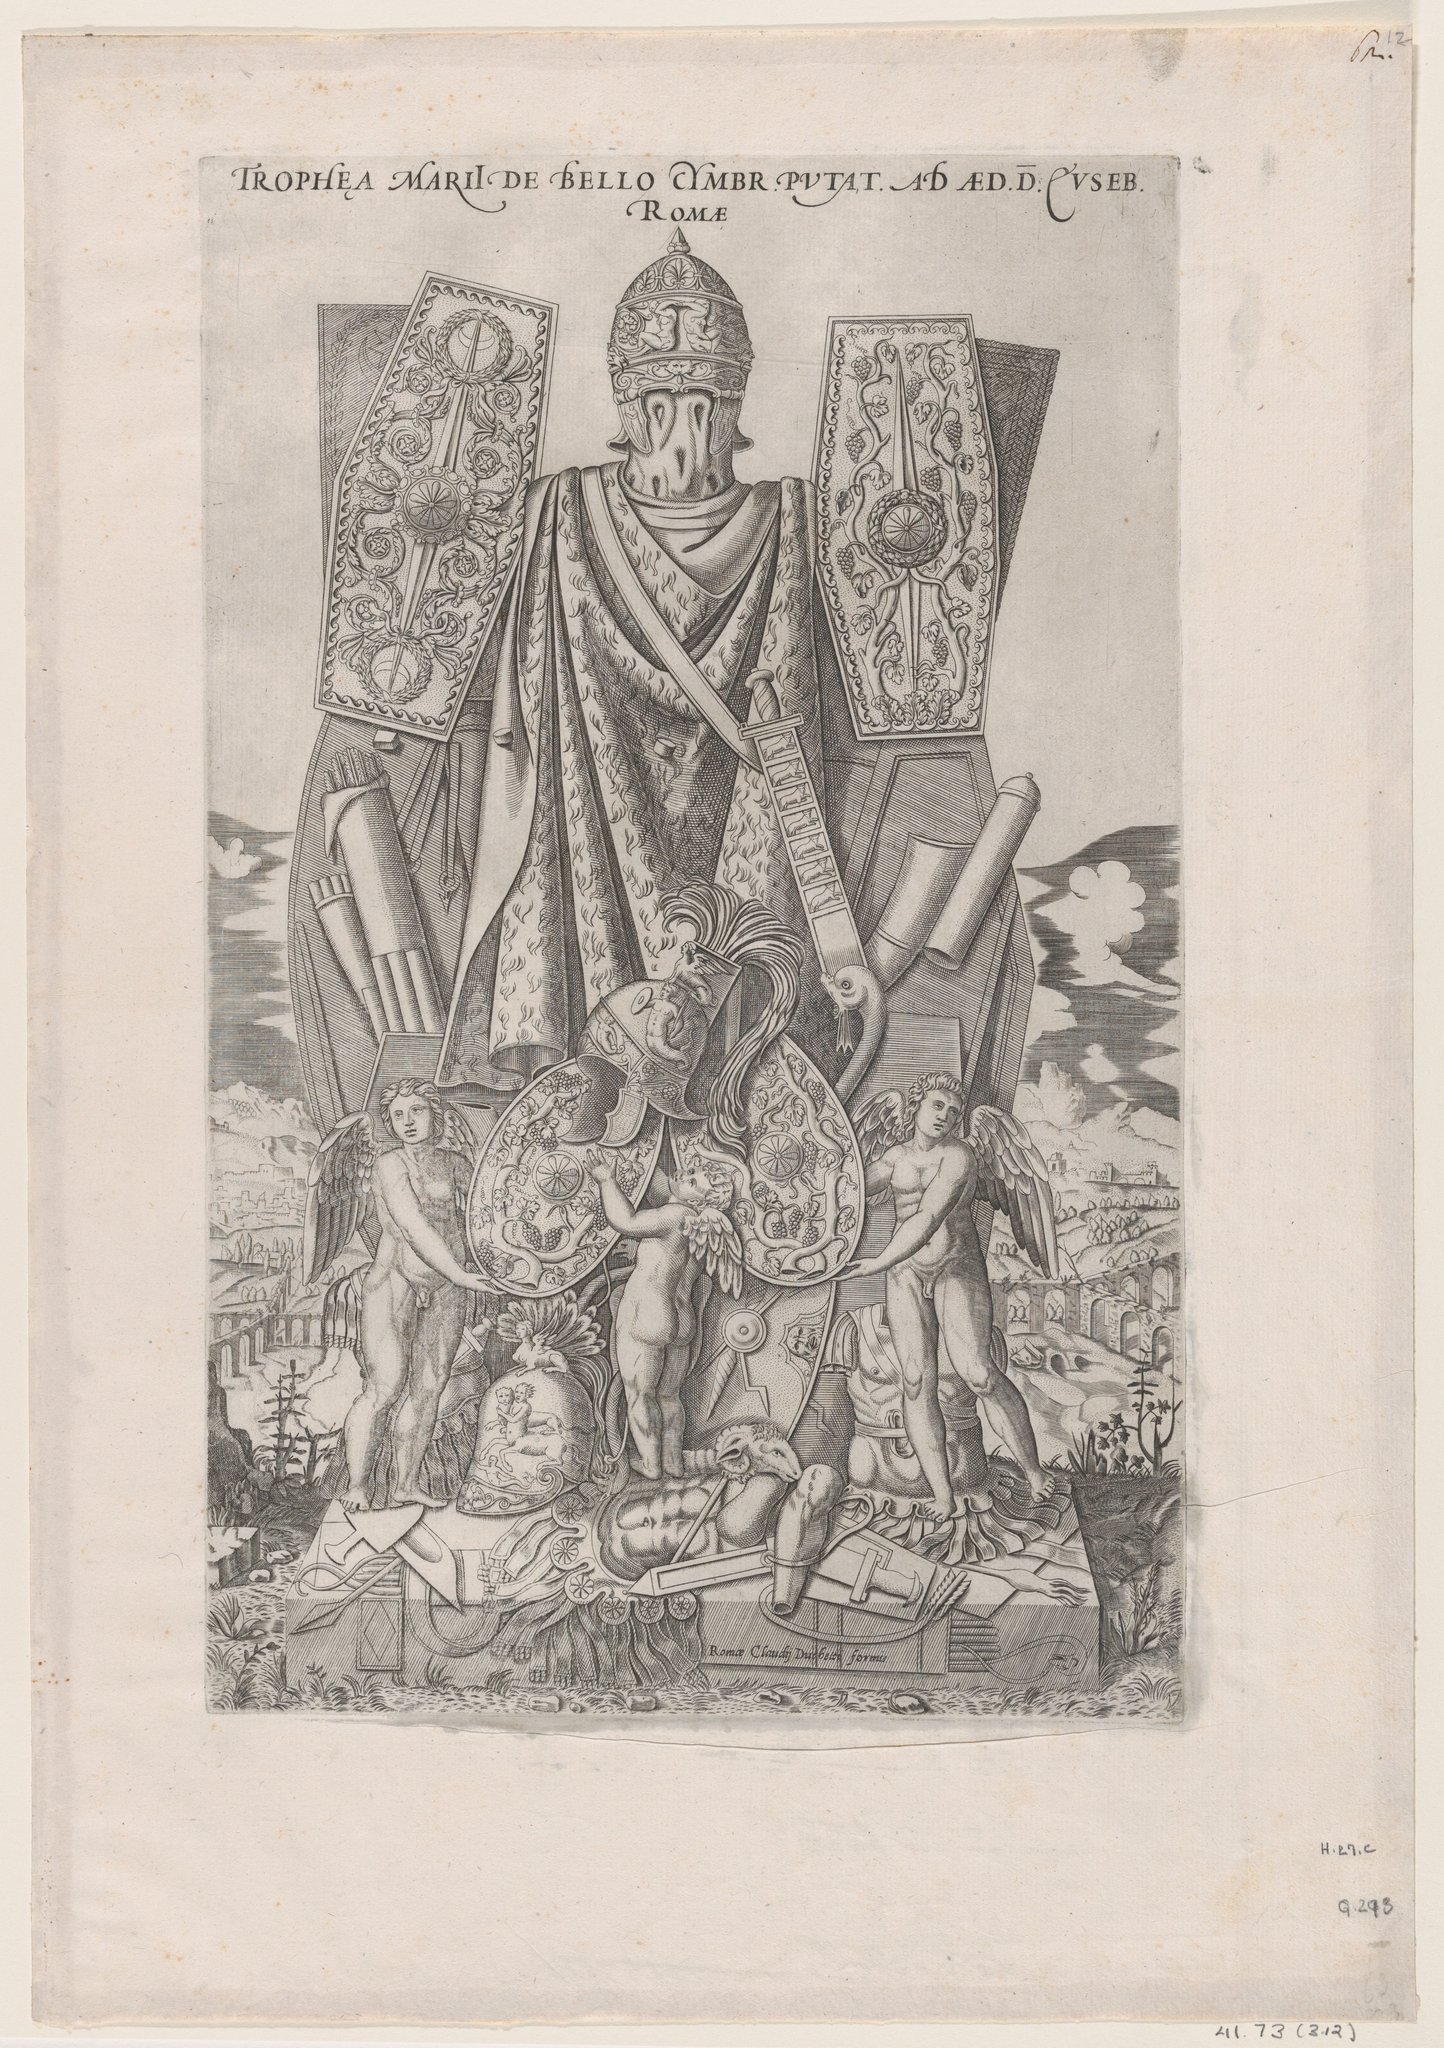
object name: print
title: Trophies of Marius, from "Speculum Romanae Magnificentiae"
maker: Anonymous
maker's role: artist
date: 1567-1600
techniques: engraving, etching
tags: helmets